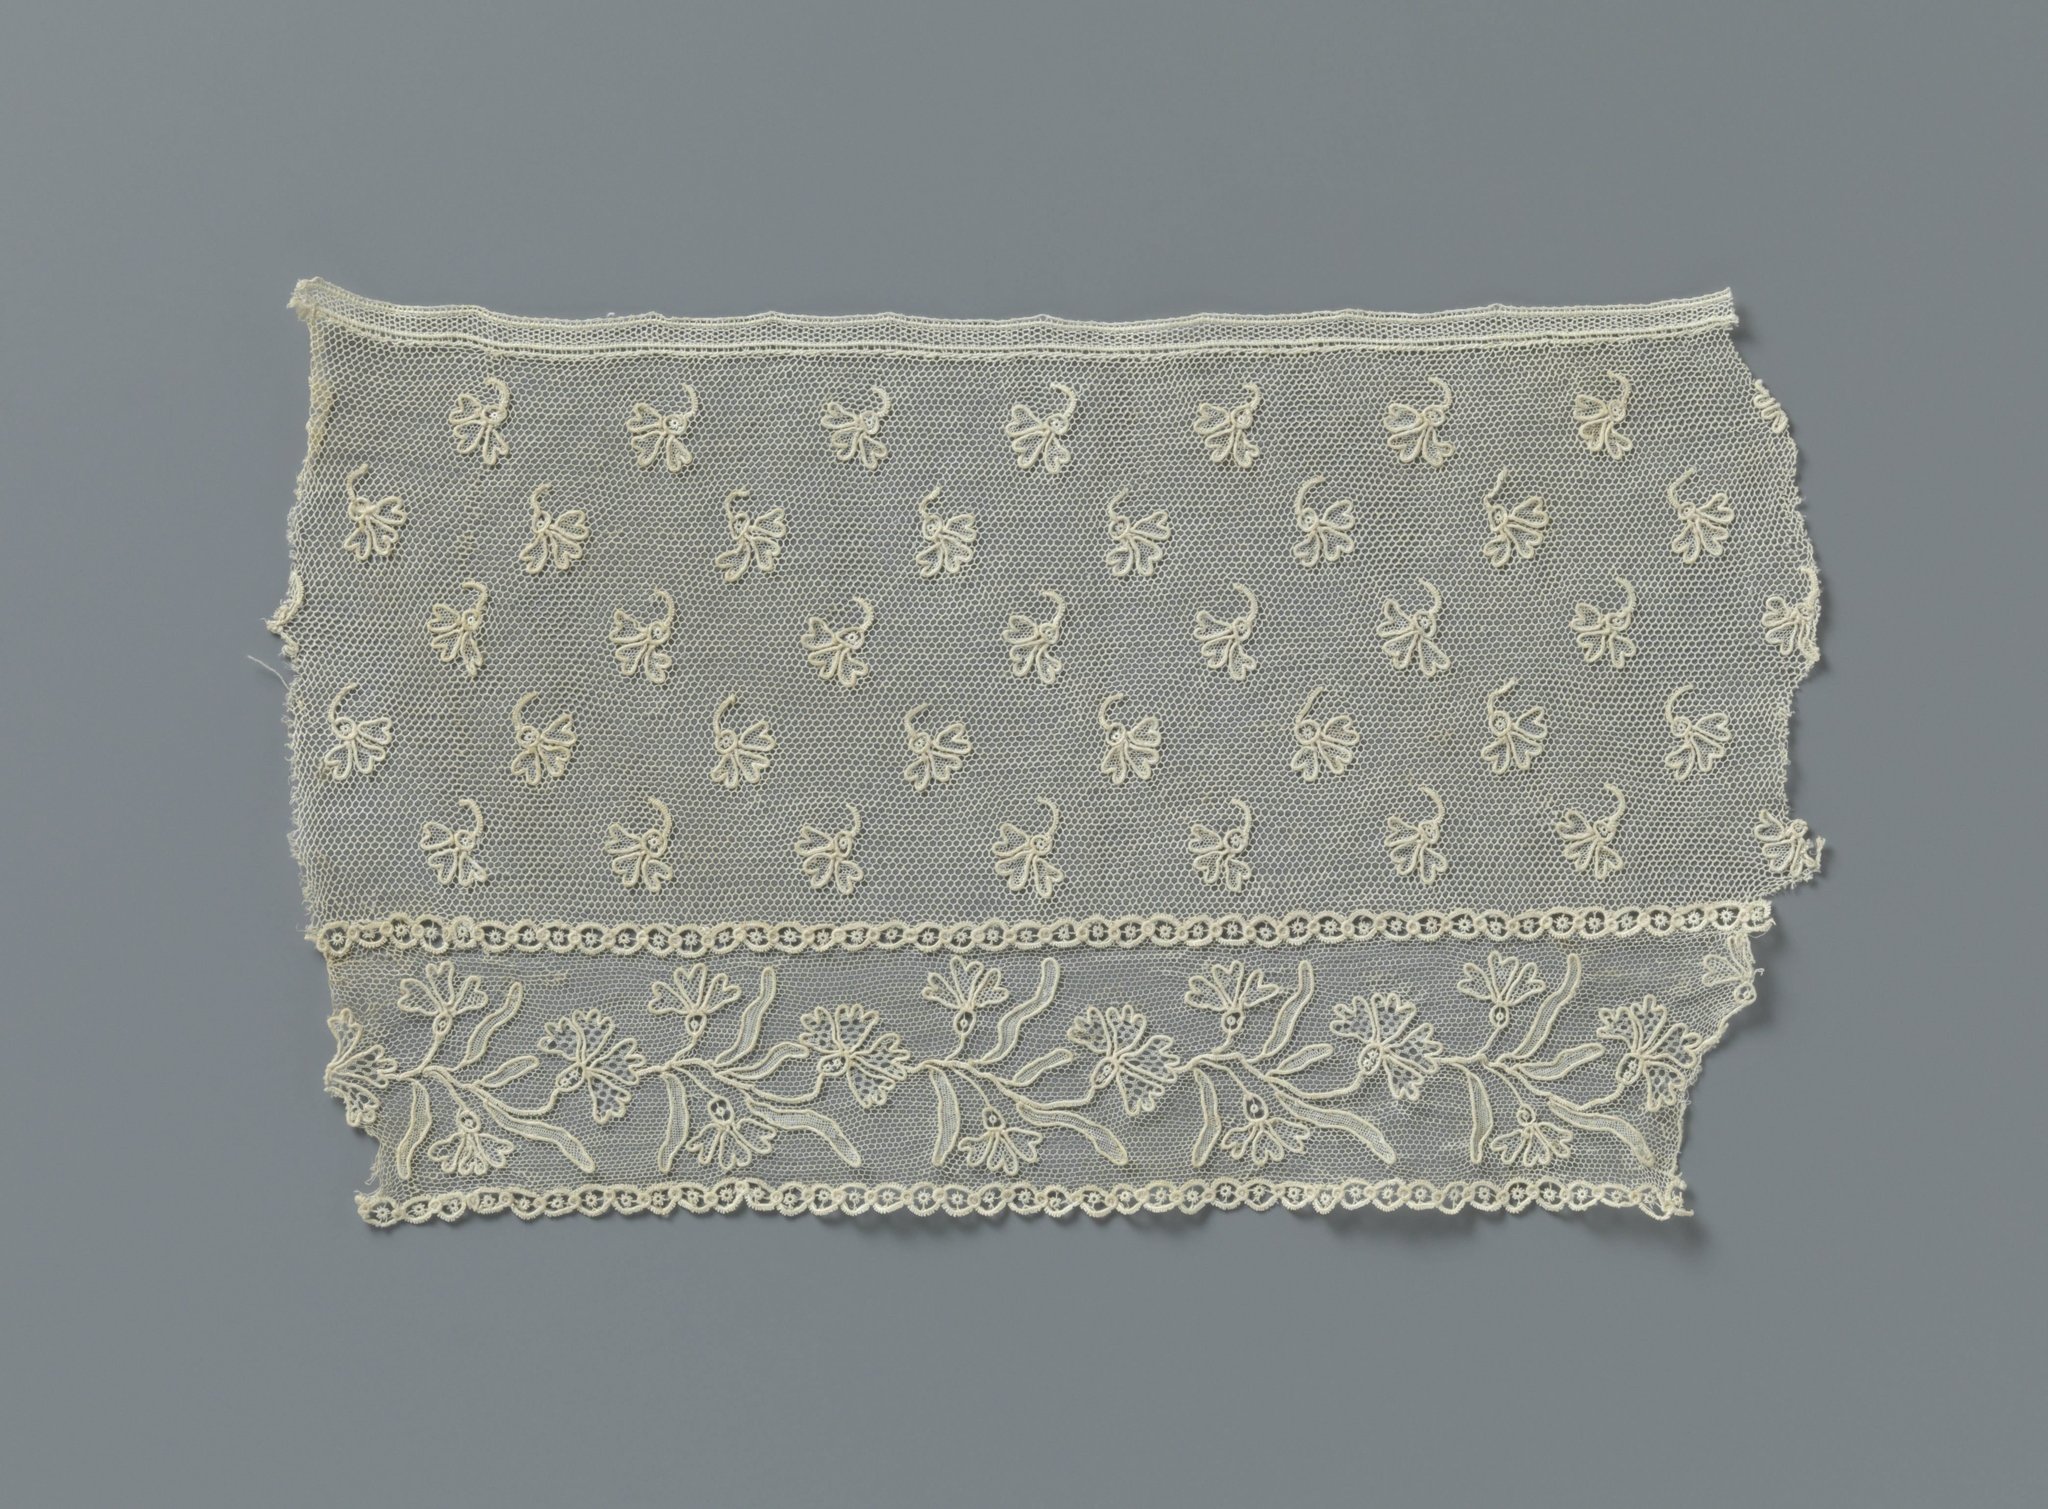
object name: strip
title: Strook naaldkant met korenbloemen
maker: Anonymous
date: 1800-1820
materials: linen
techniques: lace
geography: france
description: Tweederde van de breedte is gevuld met een strooipatroon van vallende korenbloempjes op een grof grond (van omwoelde spijlen). Een derde van de breedte vormt een recht afgesloten buitenrand (met een enkelvoudig Alençon-grond), omzoomd met twee parellijstjes, en versierd met een liggende rank van aaneengeregen stengeltjes, ieder met drie korenbloempjes, die steeds in dezelfde richting staan. Alençon-kant.